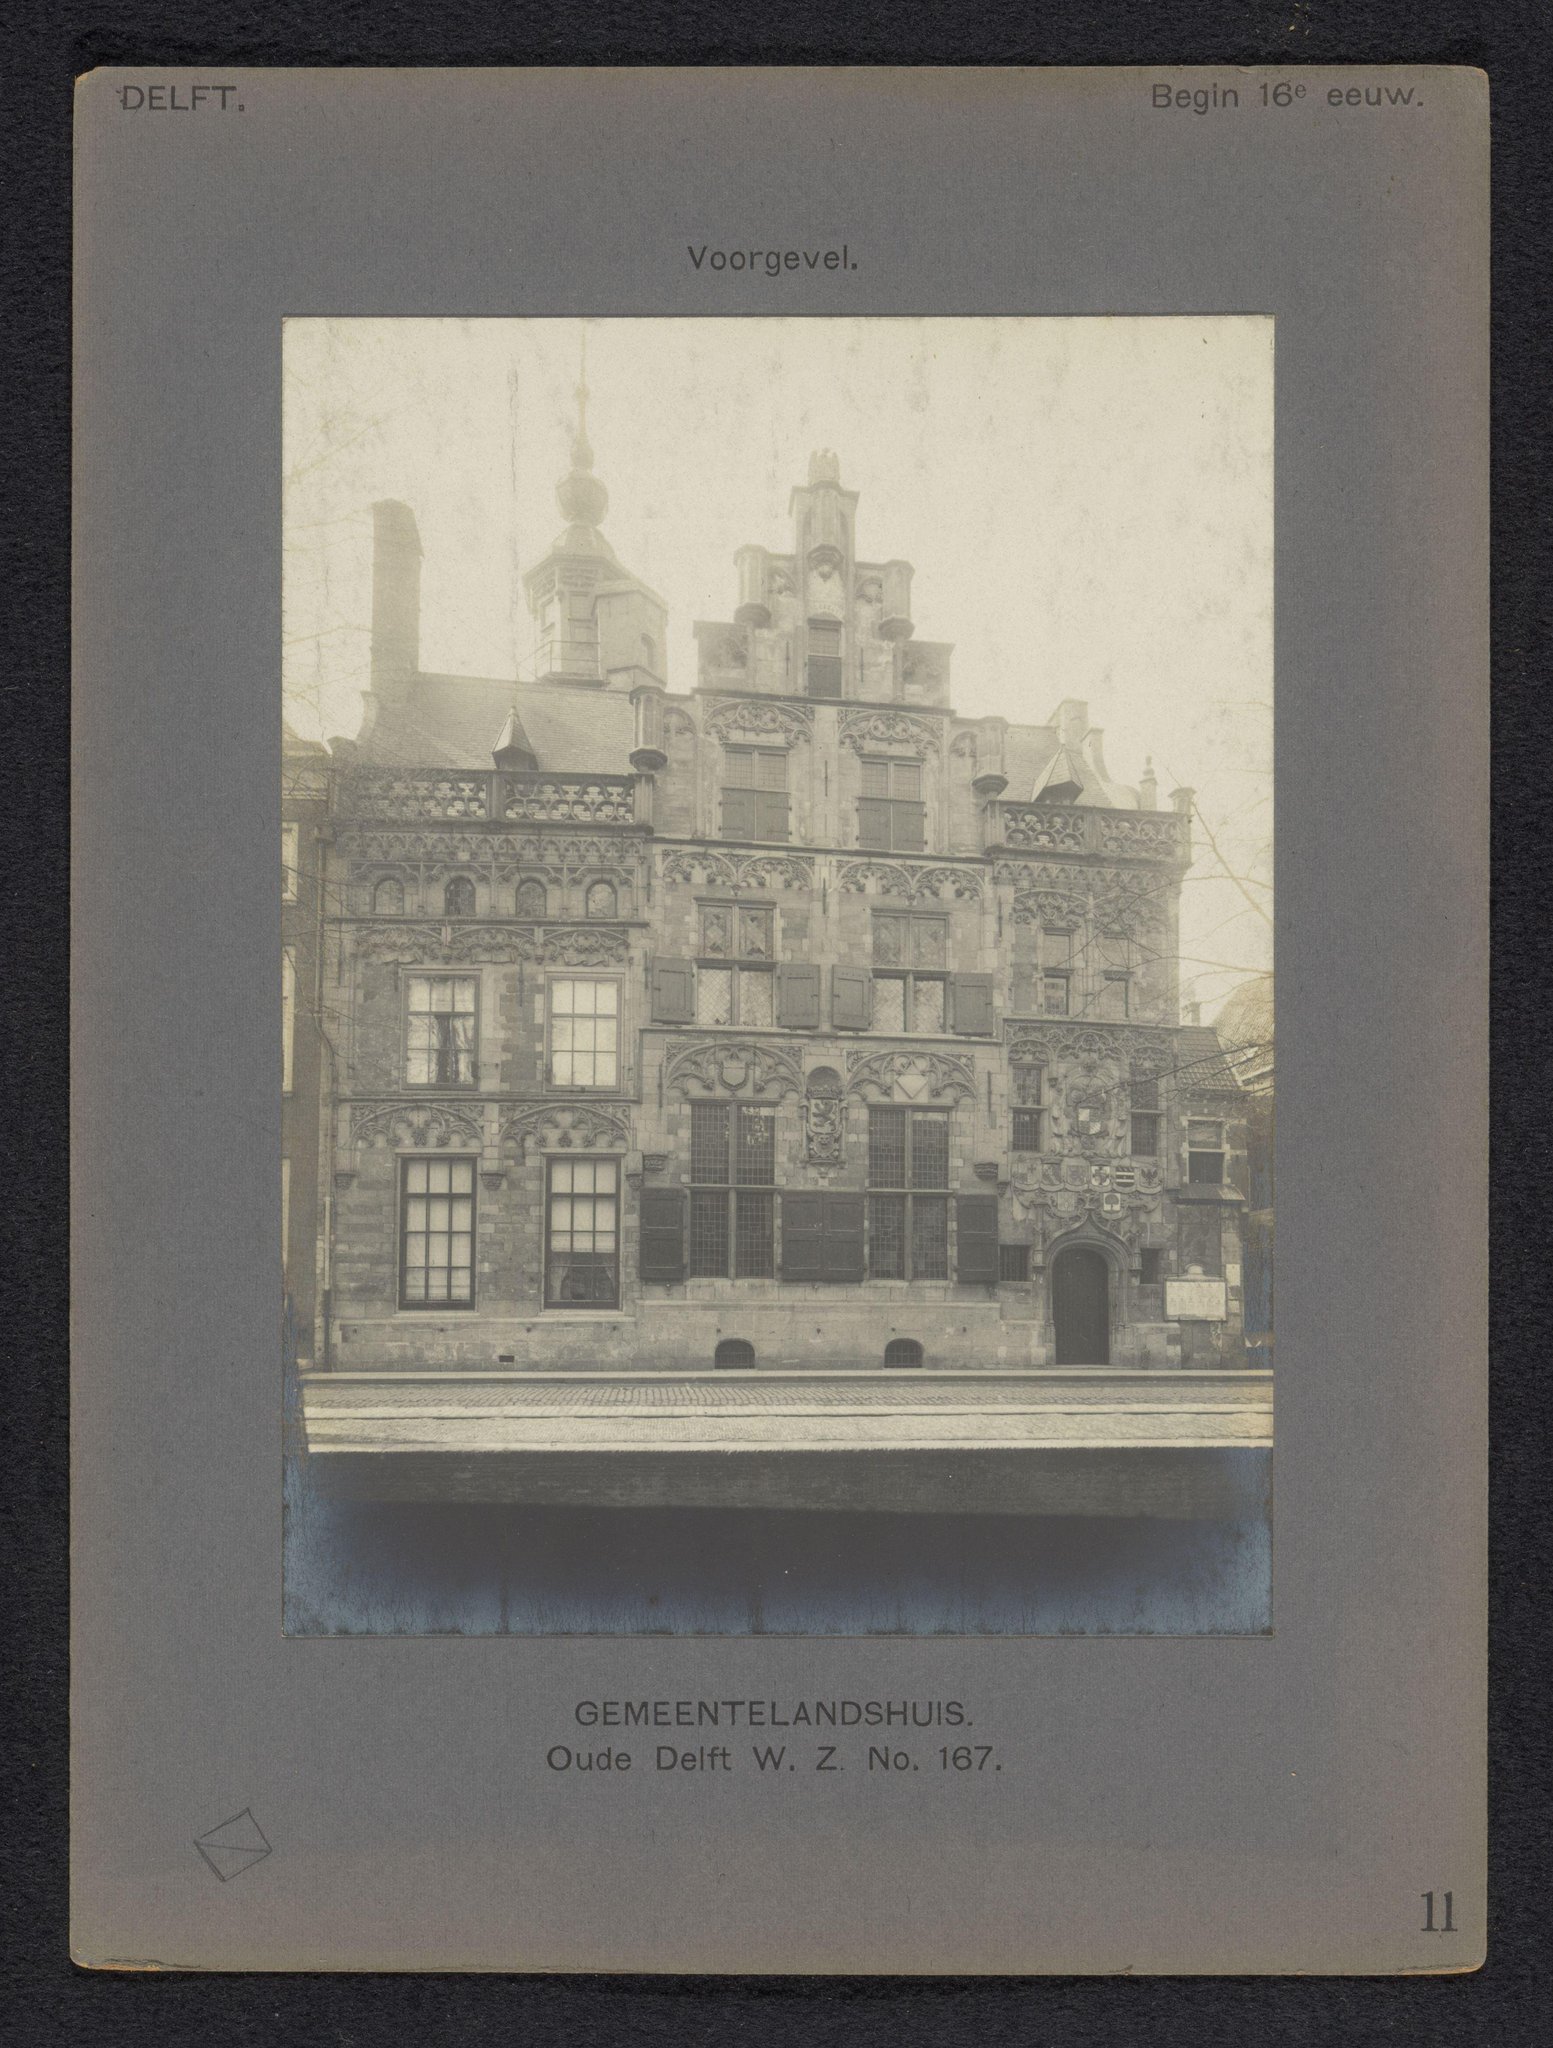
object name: photograph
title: Gemeentelandshuis. Oude Delft W.Z. No. 167. Voorgevel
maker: Anonymous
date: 1900-1904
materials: cardboard, photographic support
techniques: gelatin silver print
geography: delft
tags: gemeenlandshuis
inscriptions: number: ‘11’, inscription: ‘Het recht van reproductie dezer photo's wordt door den Uitgever voorbehouden.’, inscription: ‘Delft. Begin 16e eeuw.’